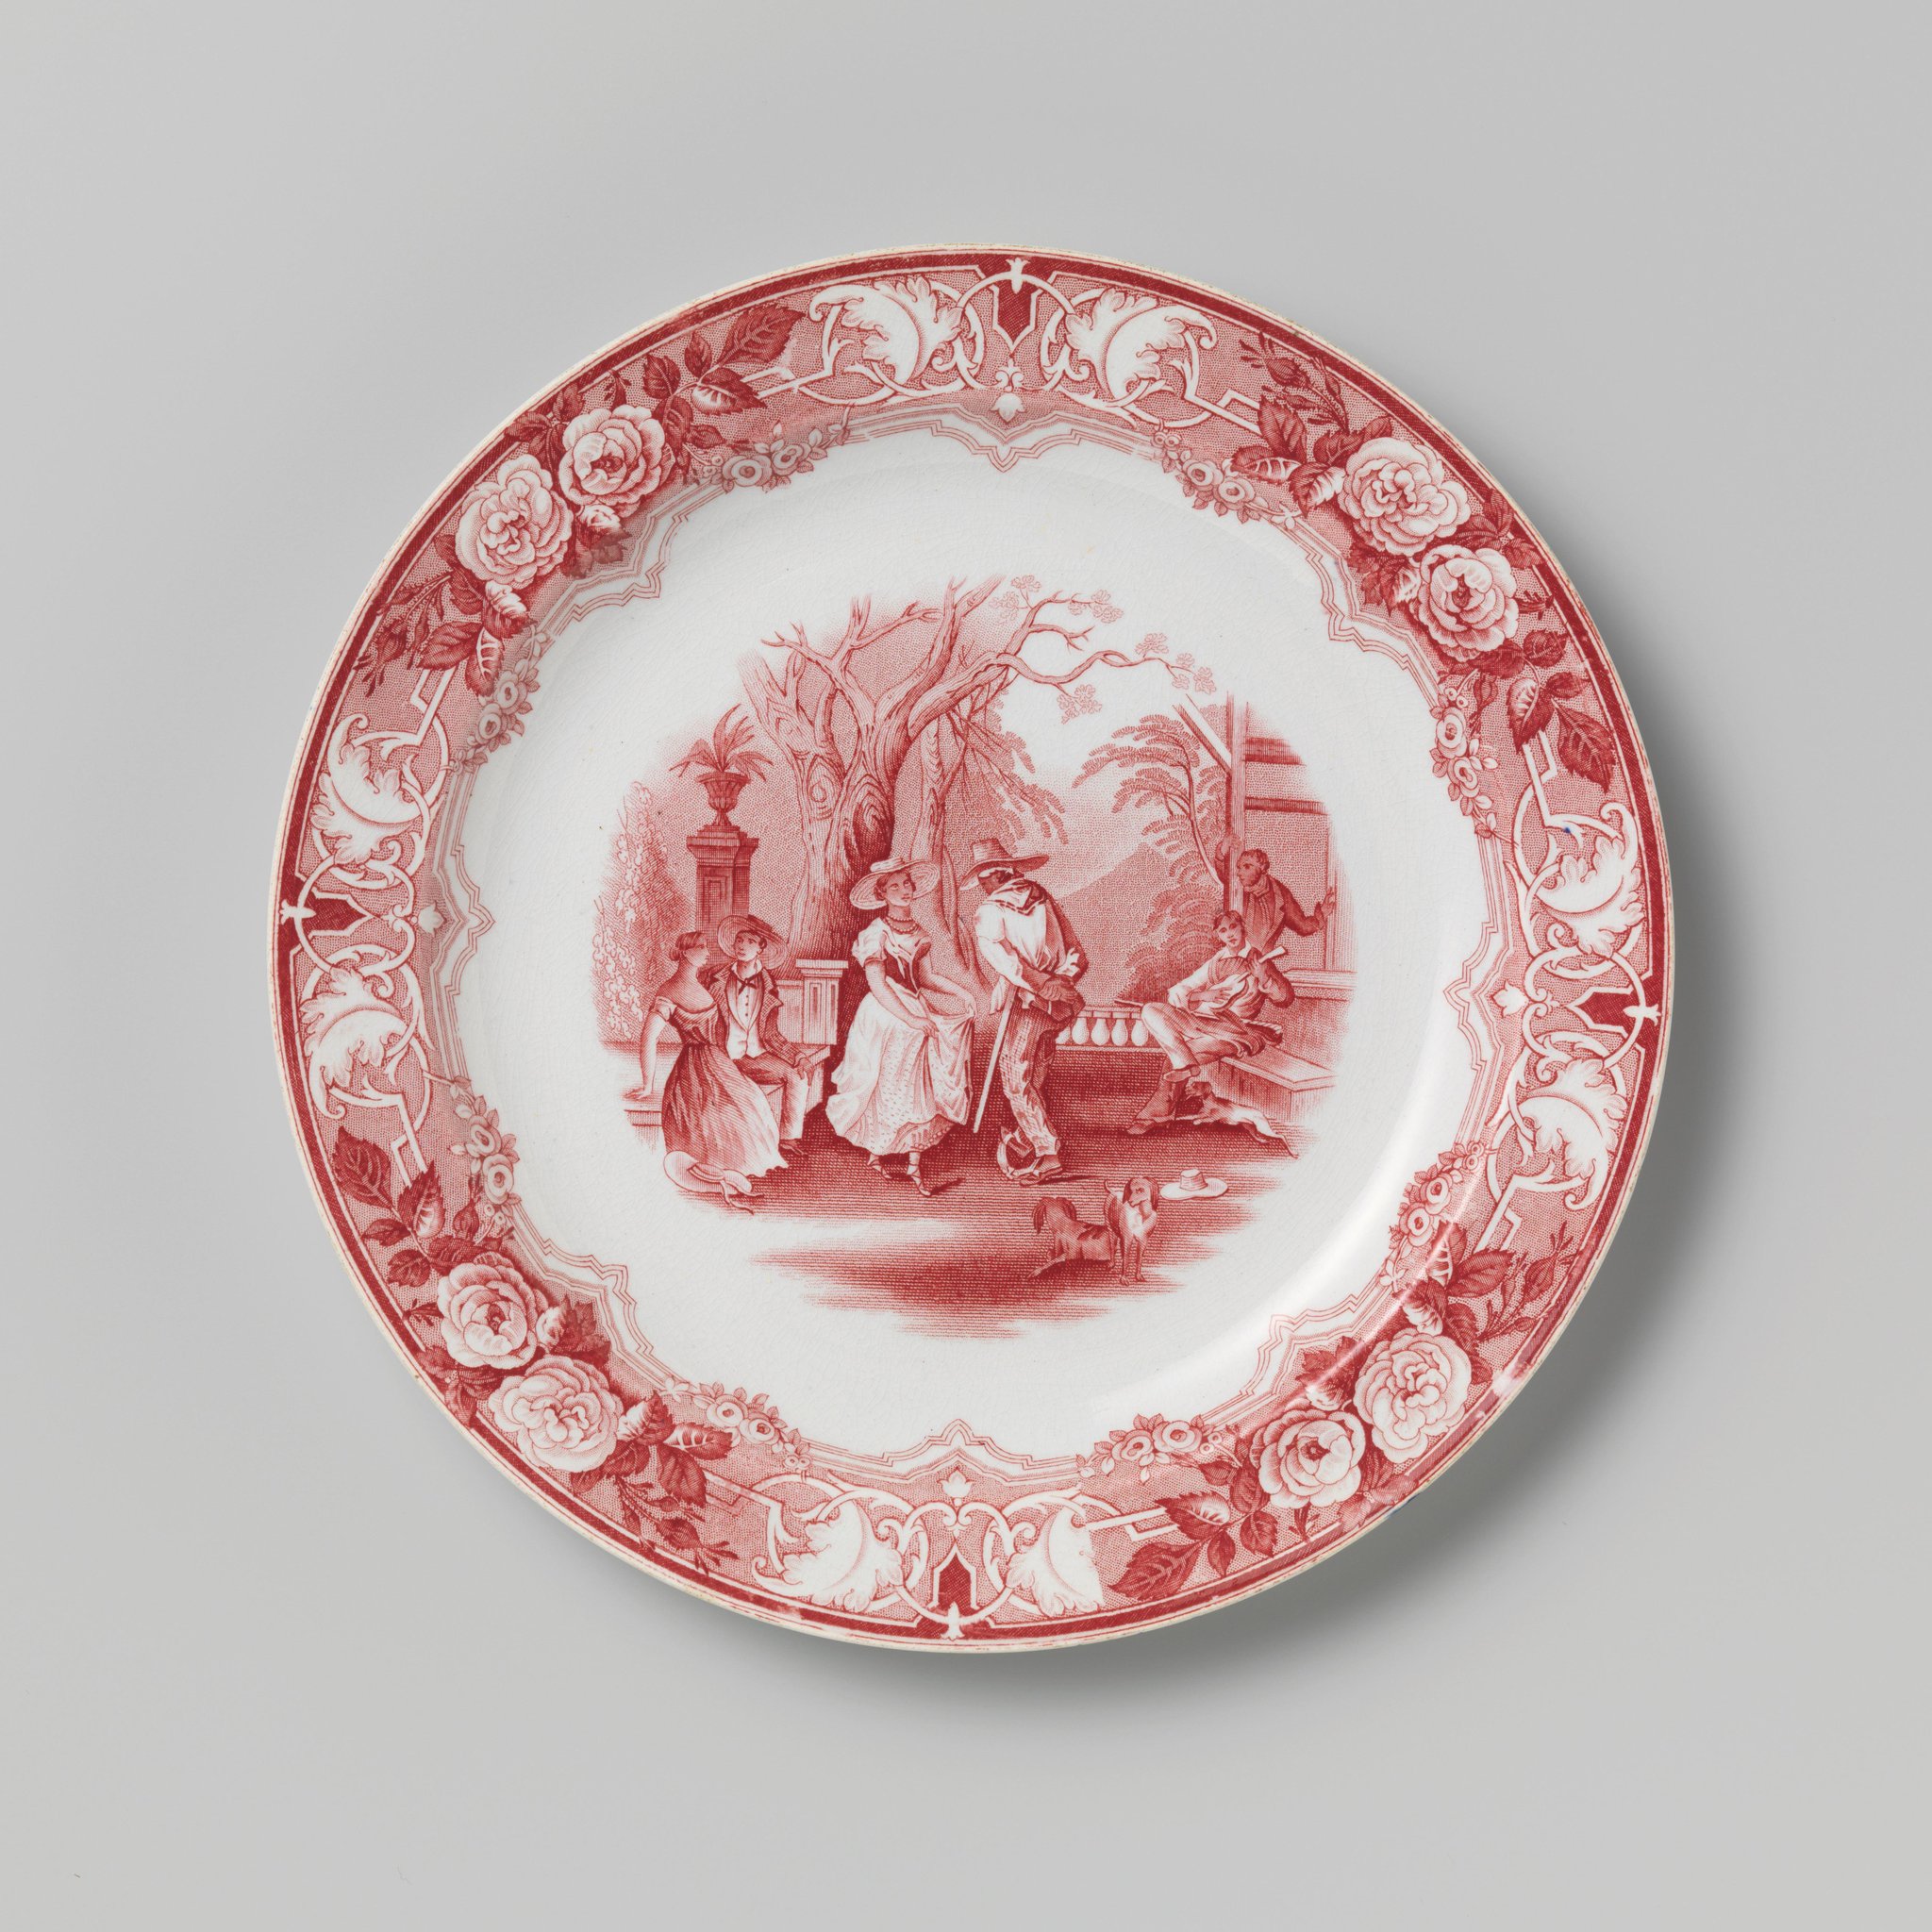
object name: plate dish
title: Bord met op het plat een voorstelling van dansers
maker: petrus regout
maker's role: plateelbakker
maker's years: 1801-1879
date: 1850-1875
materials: creamware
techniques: transfer decoration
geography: maastricht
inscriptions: mark: ‘PR // PRIZE MEDAL // 1851 // DANCING en een 3’, check stamp: ‘PR // 9’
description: Bord van aardewerk met rood transferdecor. Op het plat een voorstelling van dansers, begeleid door een gitaarspeler en enkele toeschouwers. De rand is gedecoreerd met bloemen, guirlandes en bladmotieven.